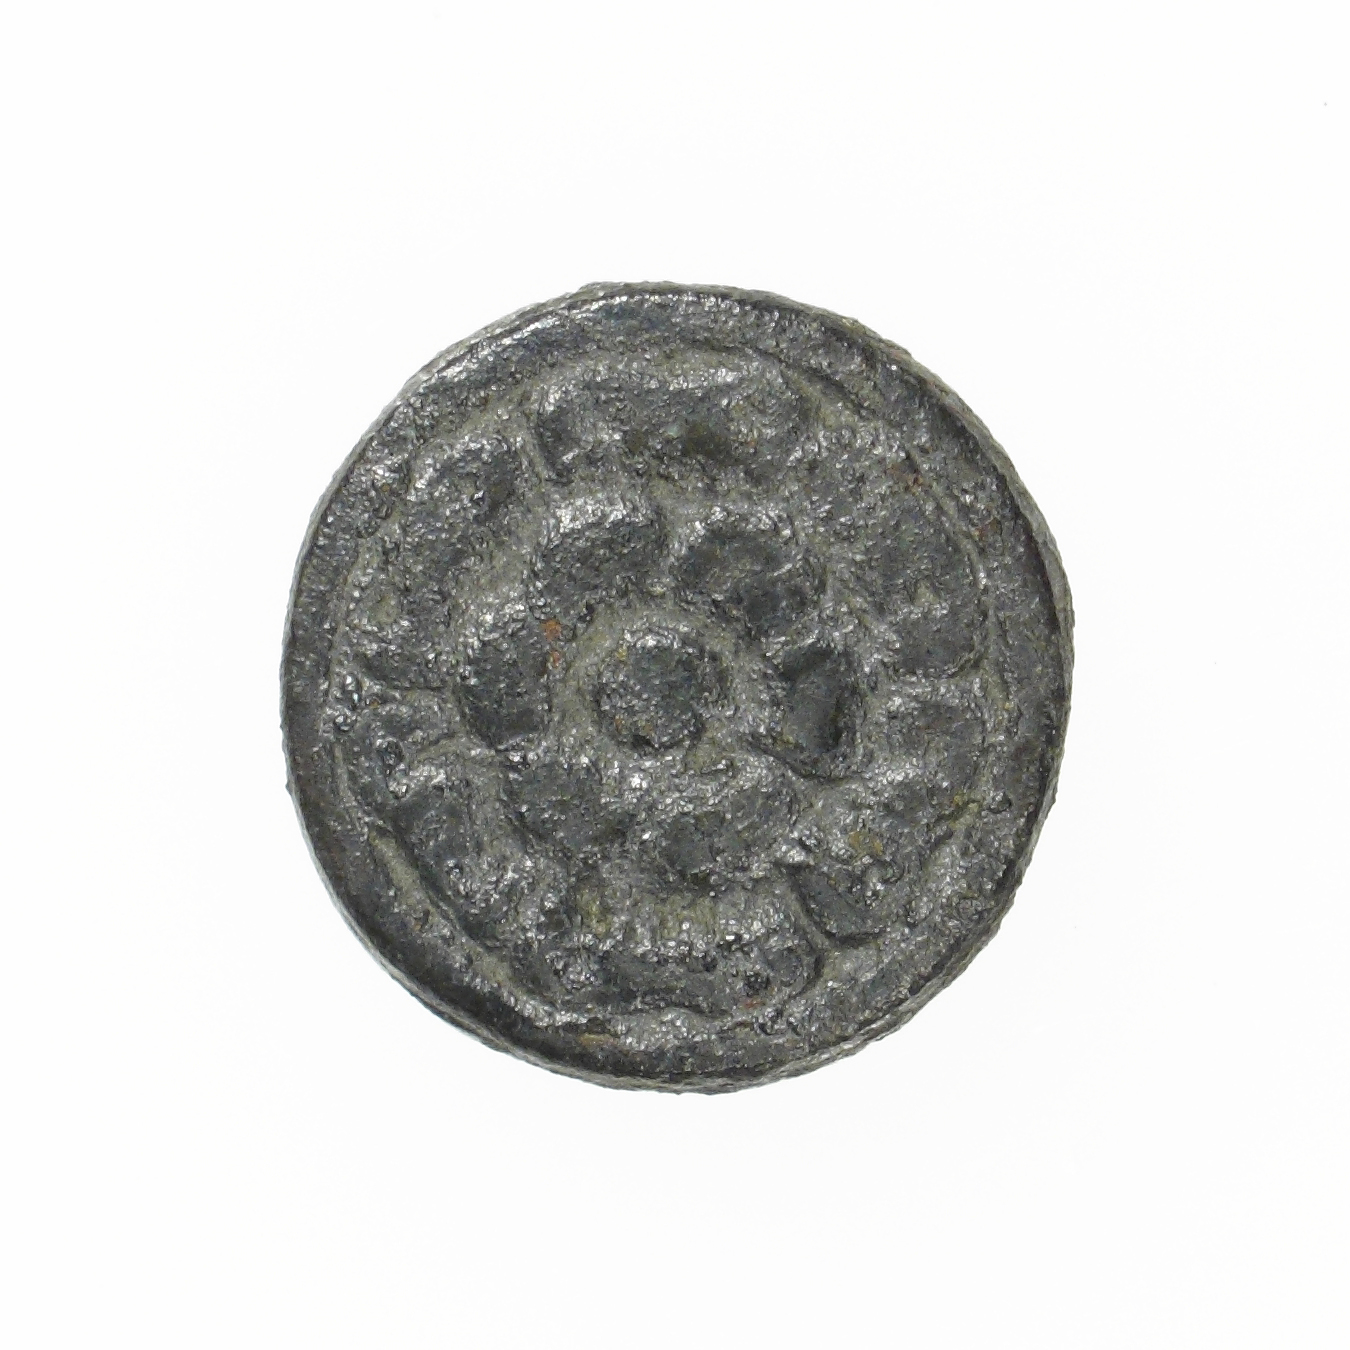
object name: pilgrim's badge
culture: french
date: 1301-1600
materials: lead